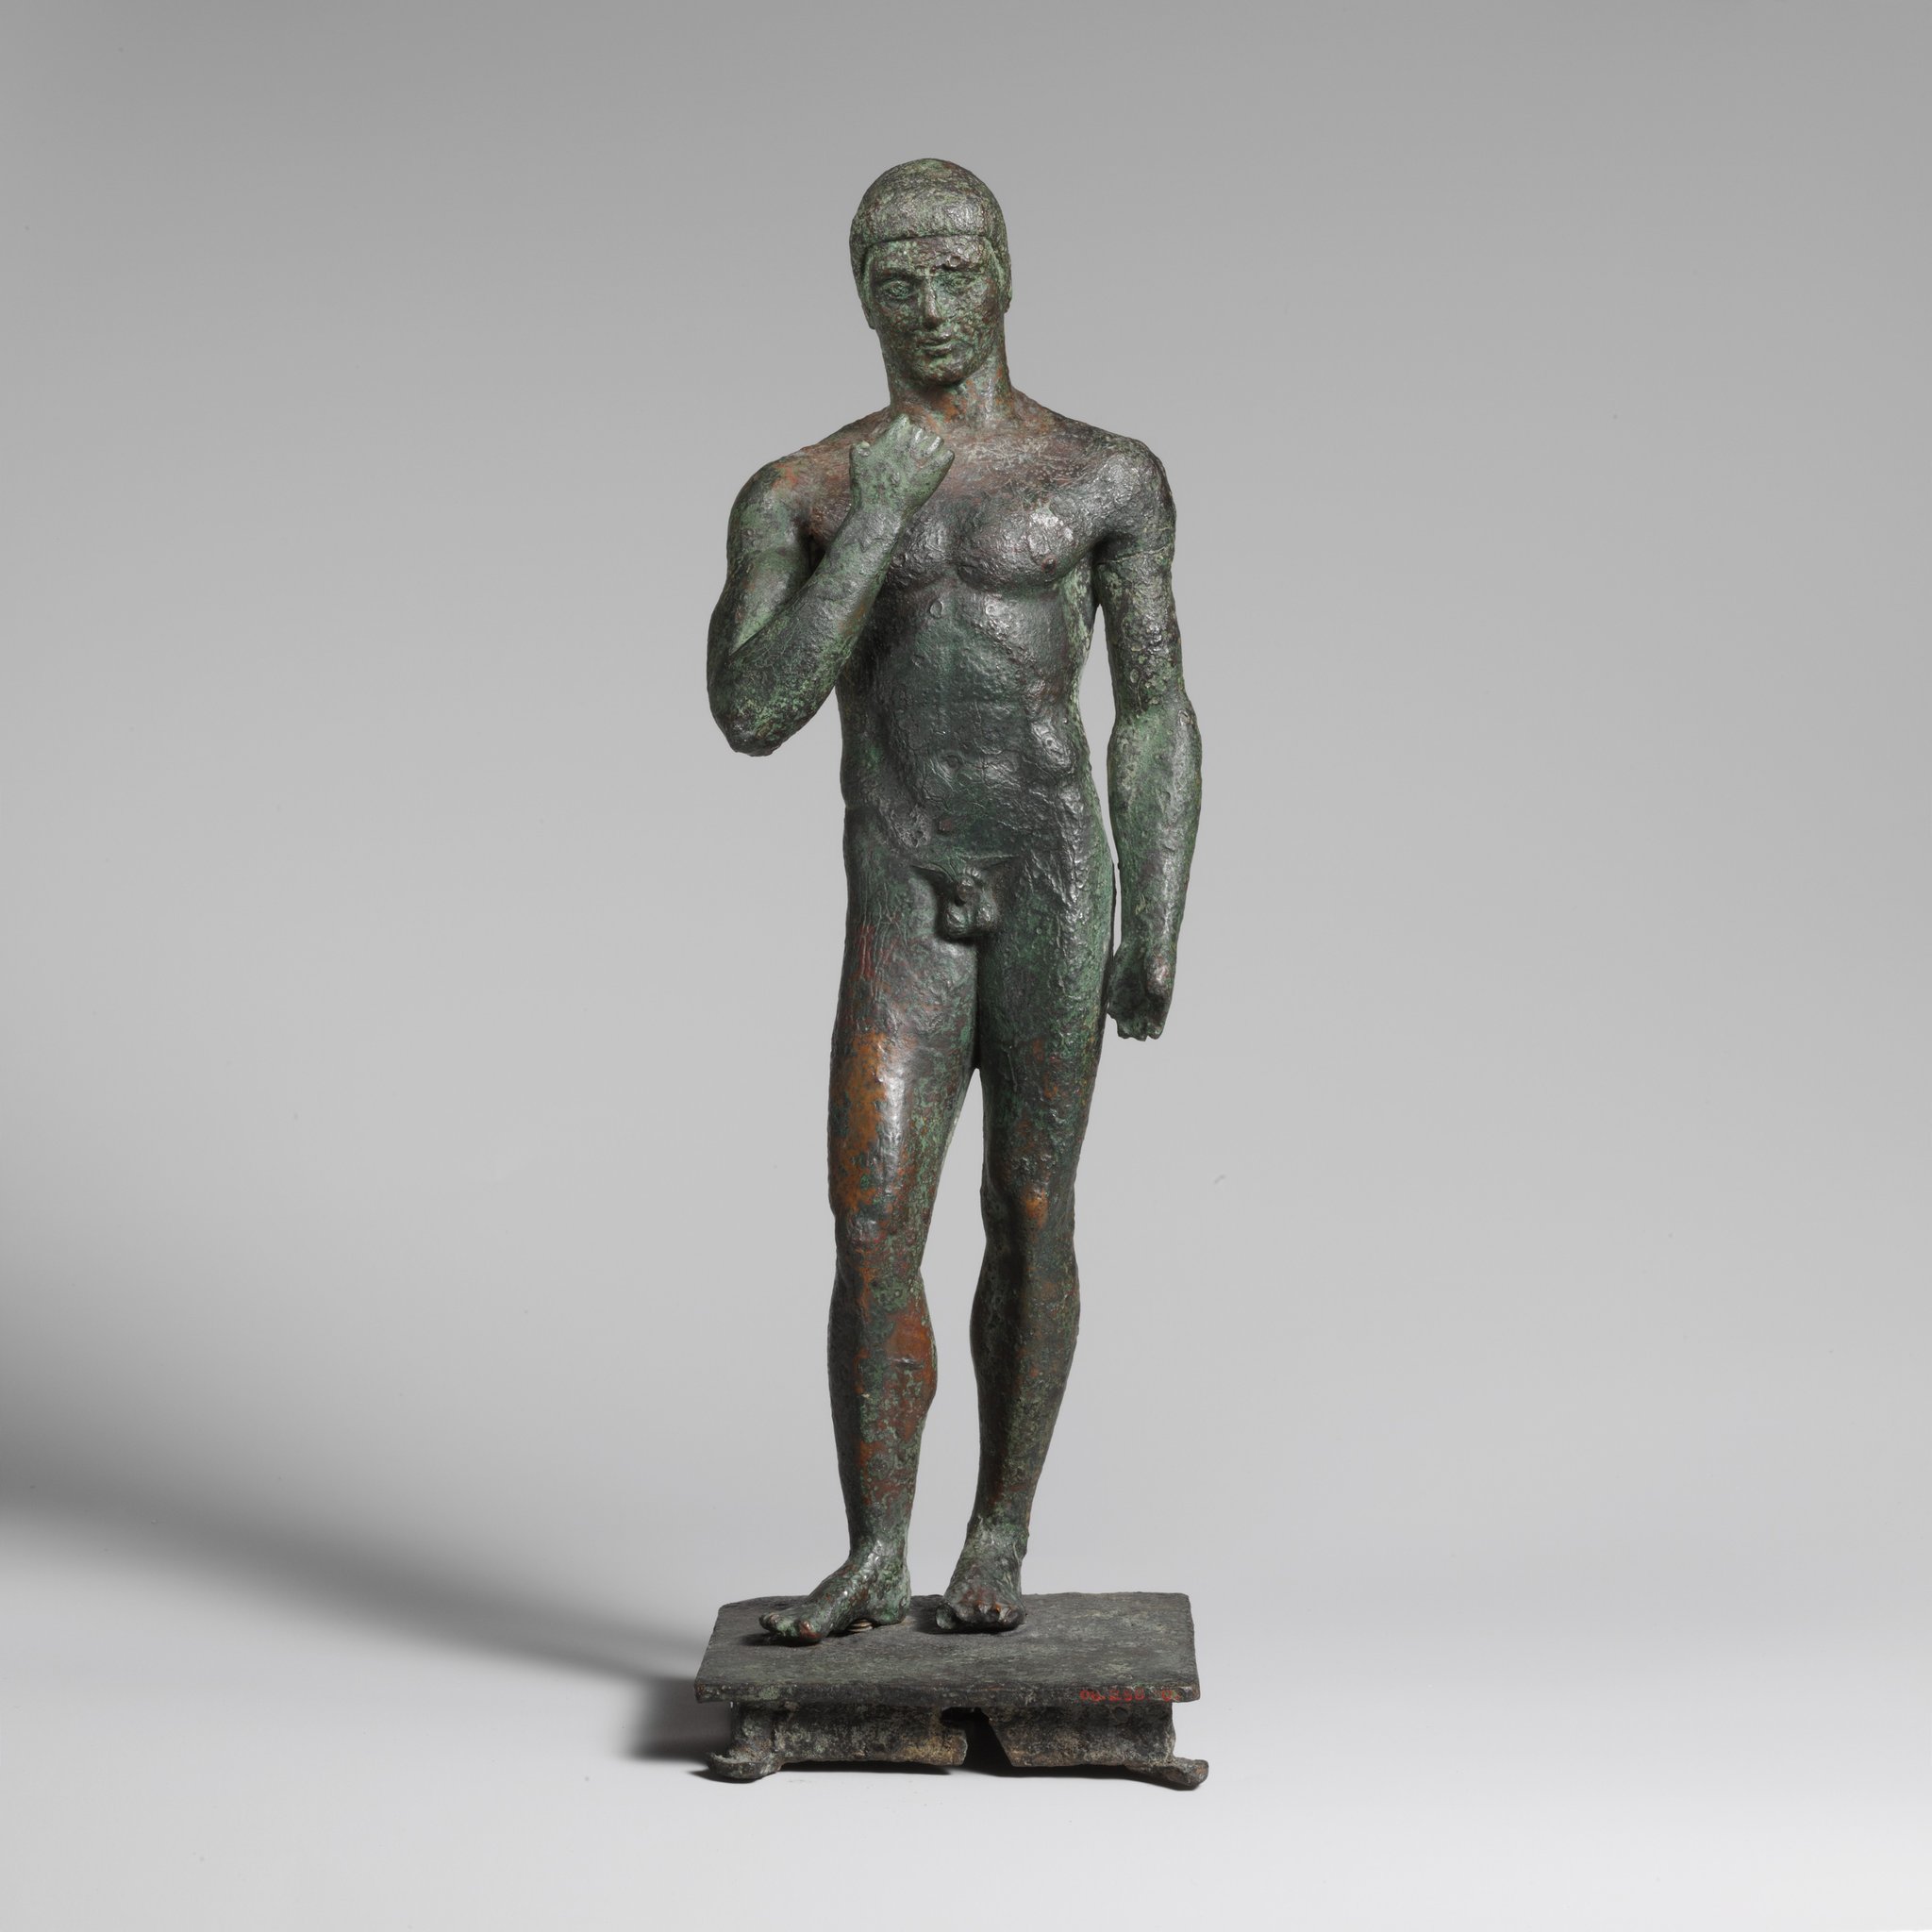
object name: statuette of a youth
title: Bronze youth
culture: greek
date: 470 BCE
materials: bronze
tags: male nudes